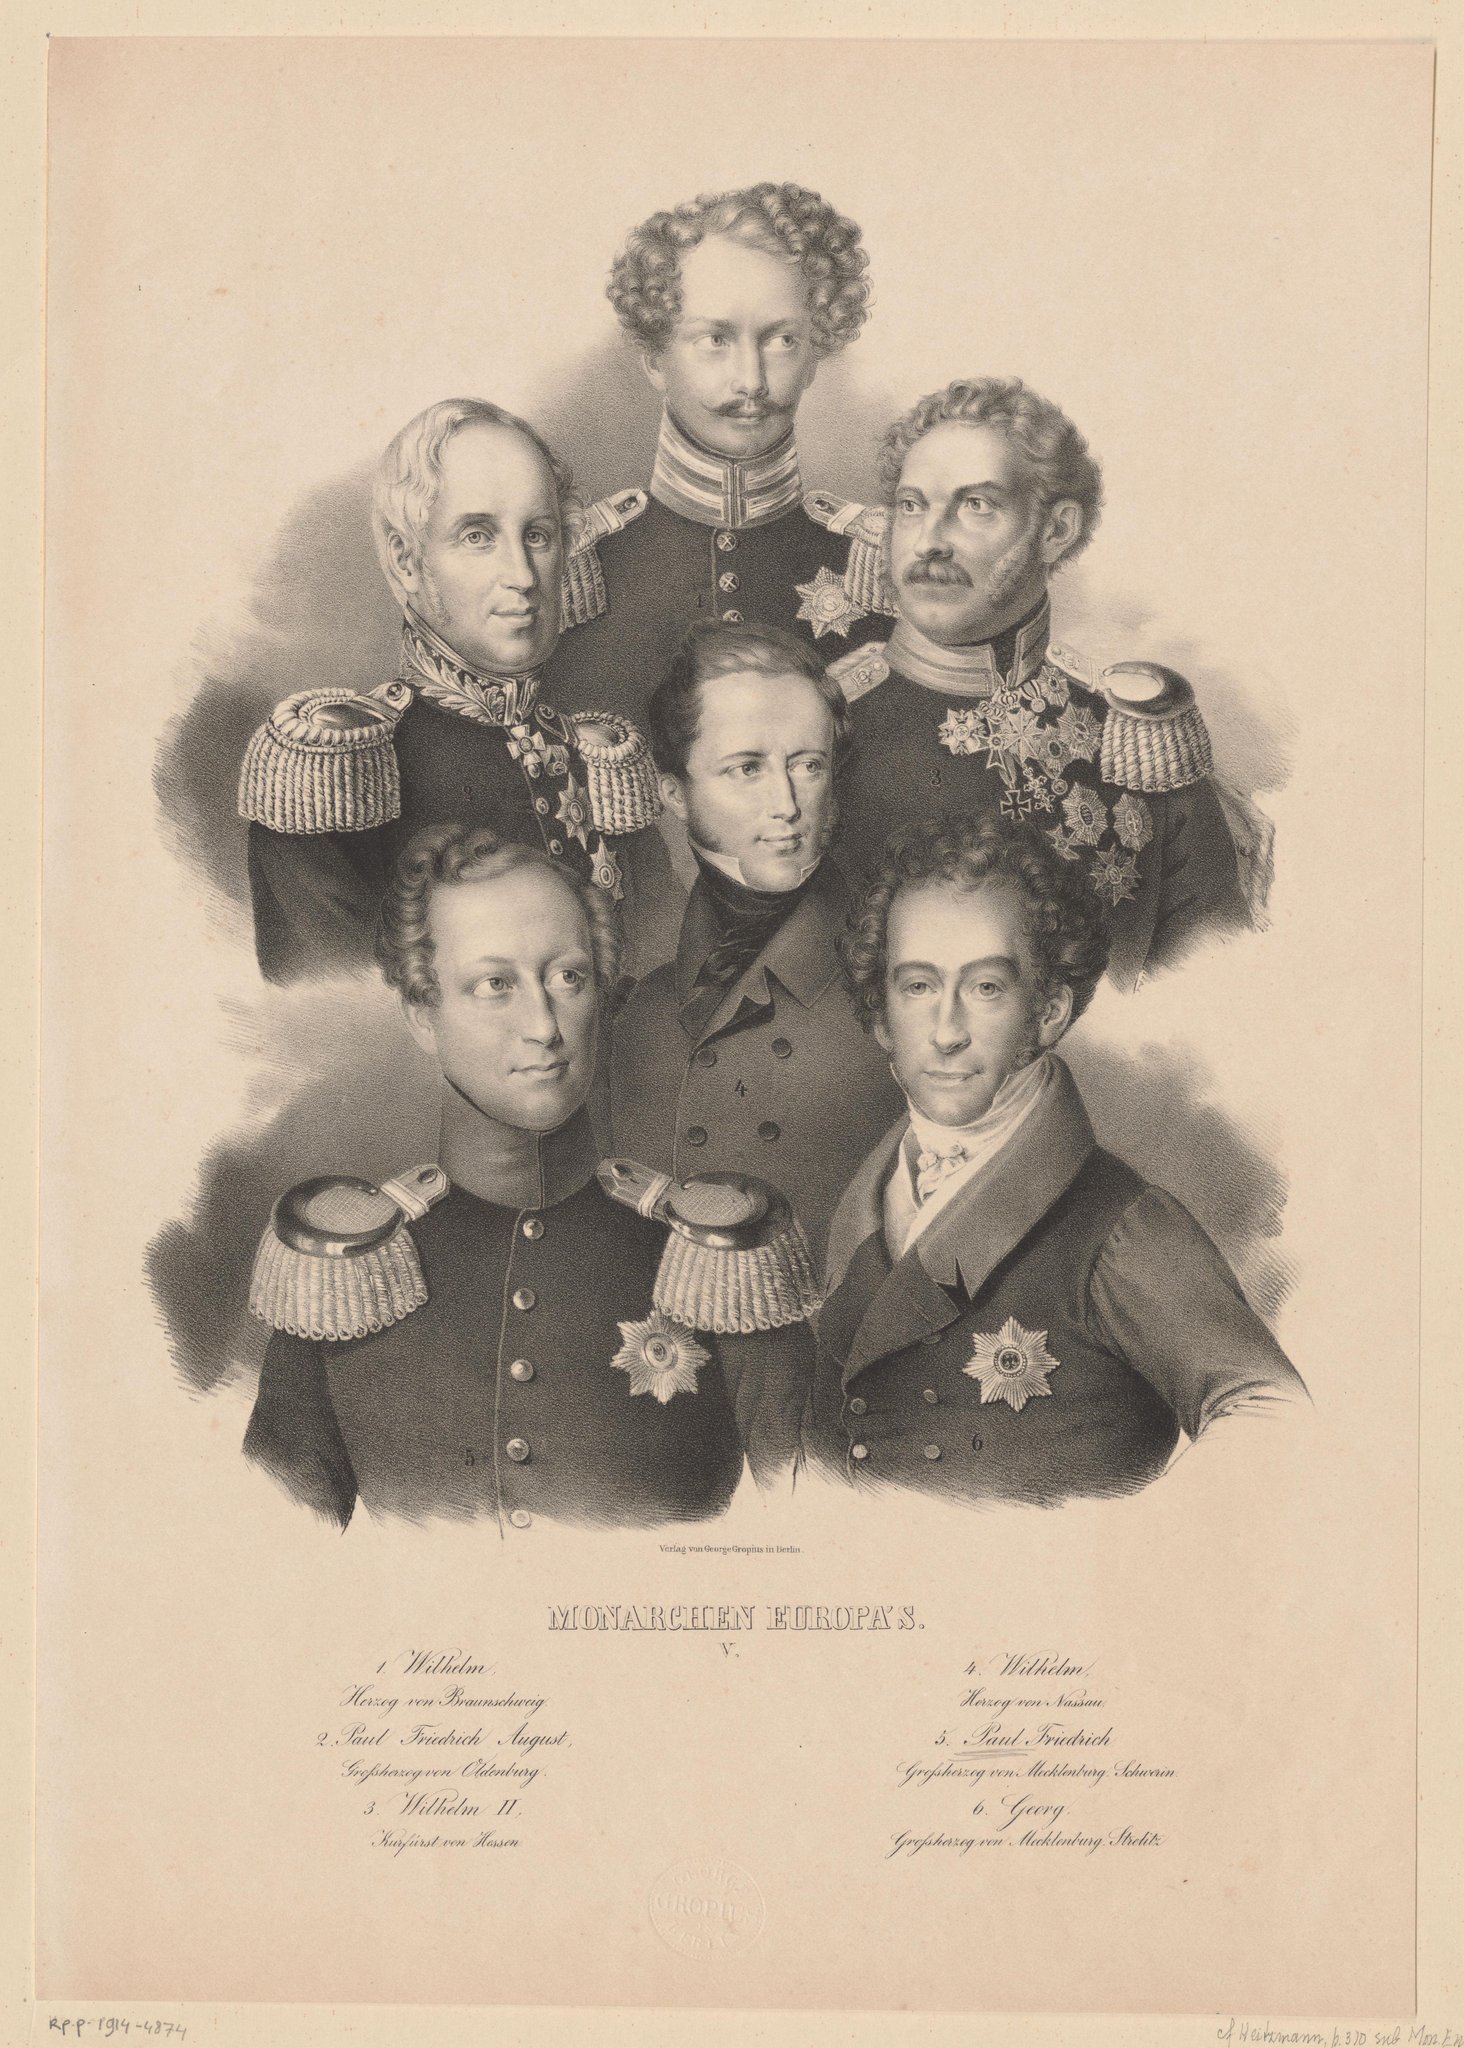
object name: print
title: Portretten van zes Europese vorsten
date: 1830-1842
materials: paper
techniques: lithograph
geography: berlin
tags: august van oldenburg, willem van brunswijk, historical persons, ranks ~ rulers, sovereigns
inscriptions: collector's mark: Lugt 2228, check stamp: Lugt 4221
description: Portretten van Wilhelm August von Braunschweig-Lüneburg, Wilhelm II (keurvorst van Hessen-Kassel), Paul Friedrich (groothertog) Mecklenburg-Schwerin, Georg von Mecklenburg-Strelitz, August van Oldenburg, en van Willem van Nassau.